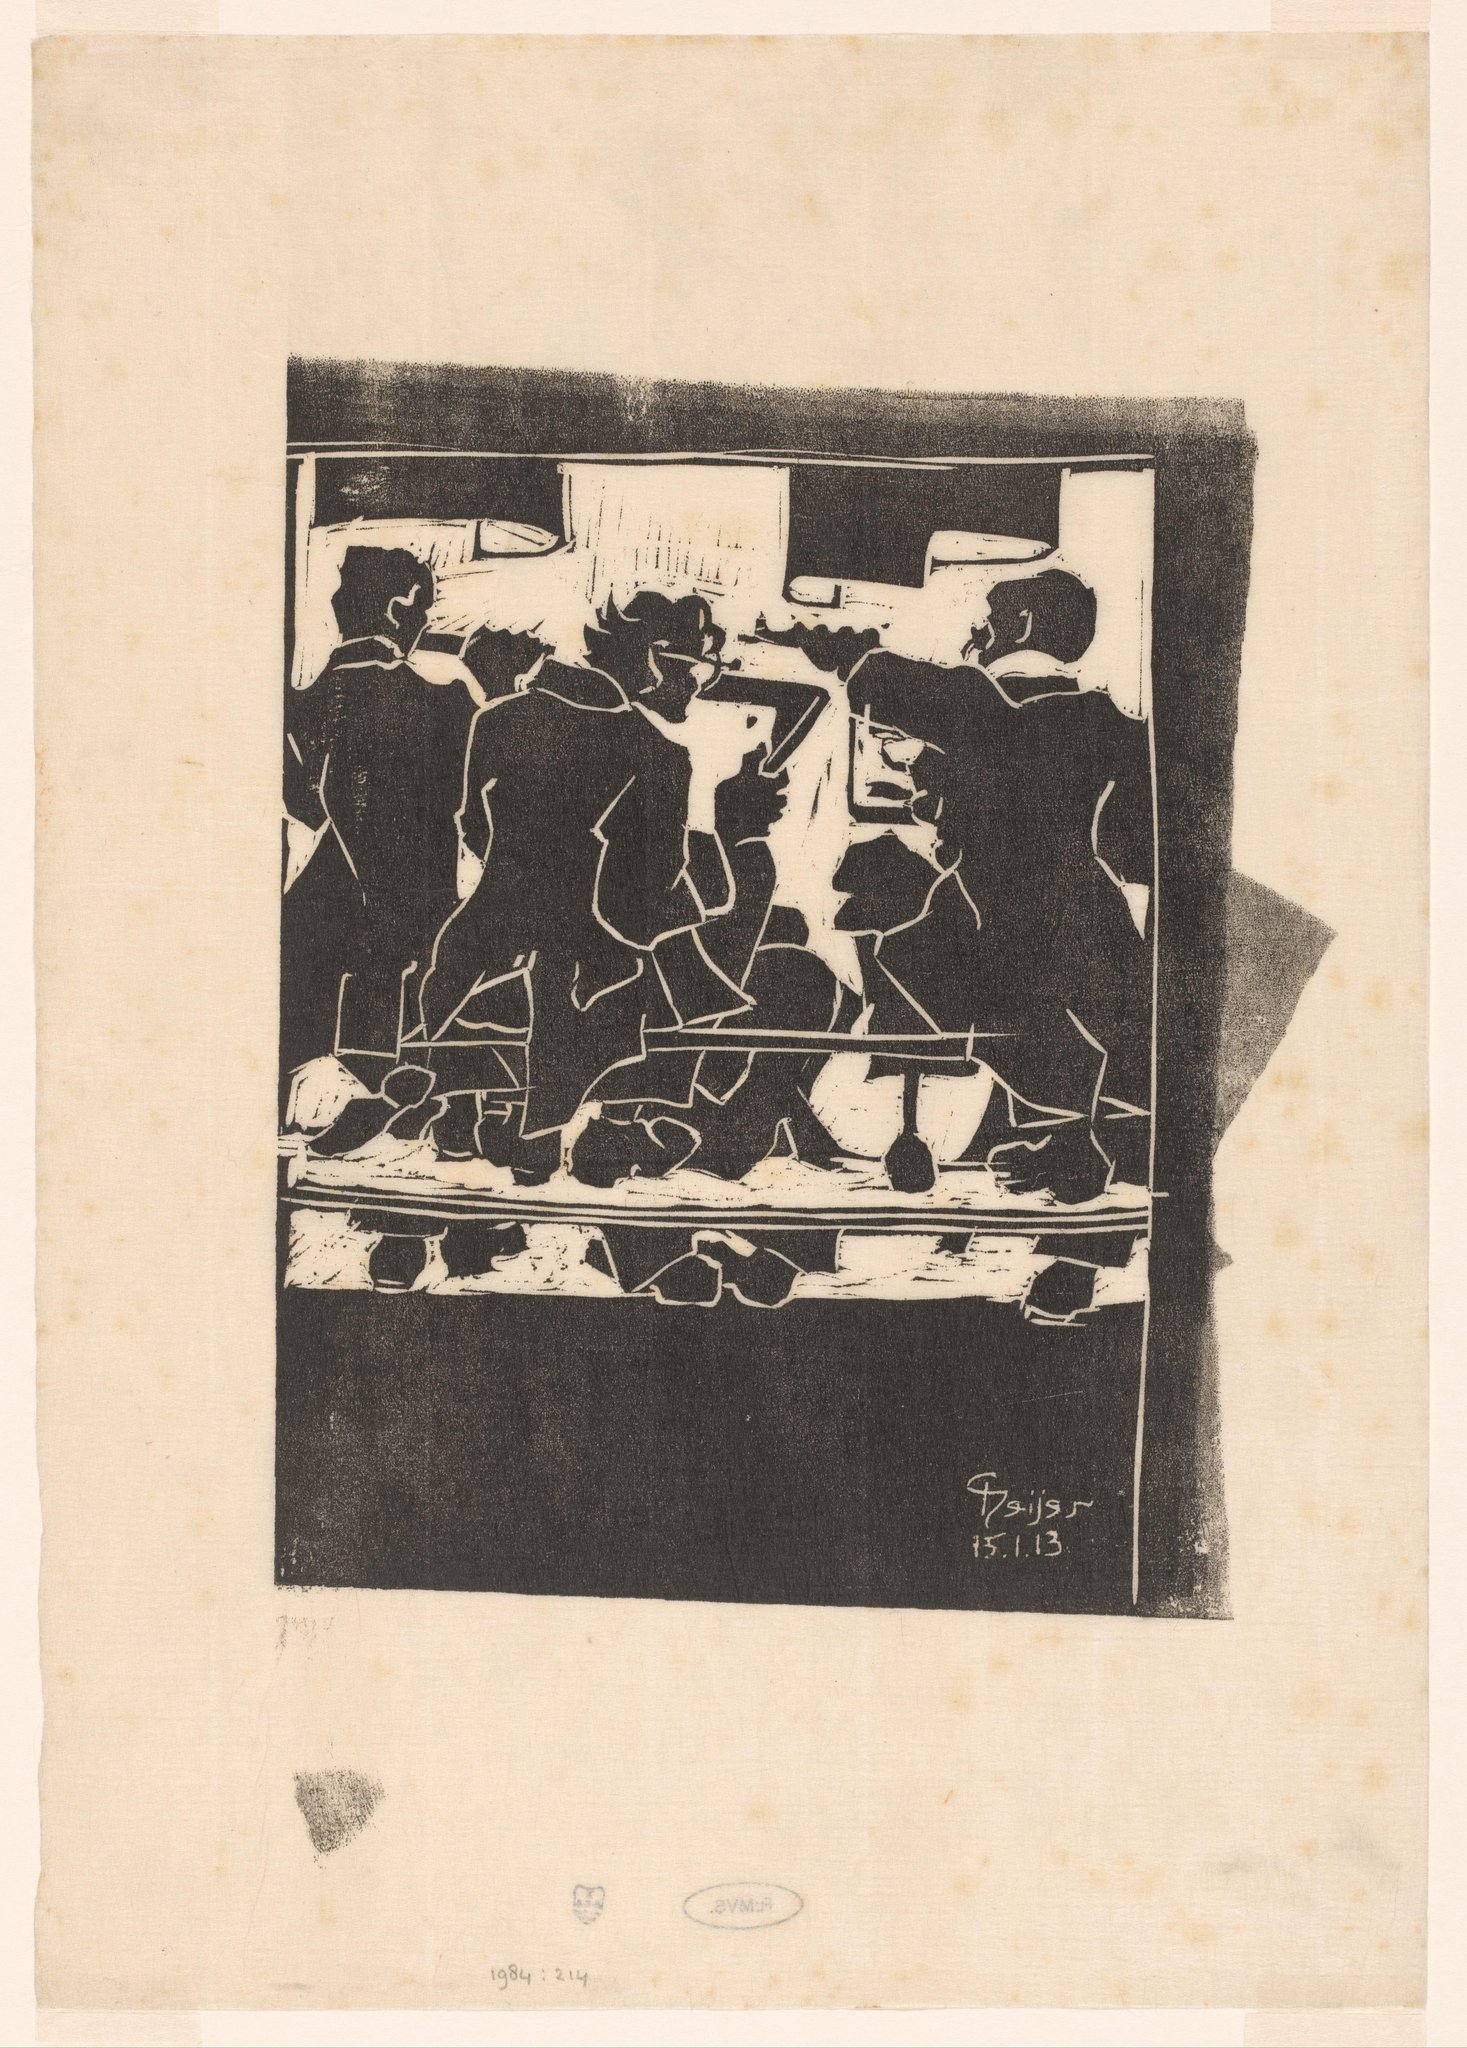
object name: print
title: Drie muzikanten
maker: reijer stolk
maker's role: draughtsman, print maker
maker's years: 1896-1945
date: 1913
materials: paper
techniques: woodcut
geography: netherlands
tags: musician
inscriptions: collector's mark: Lugt 2760, collector's mark: Lugt 2228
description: Drie muzikanten in kostuum op de rug gezien.